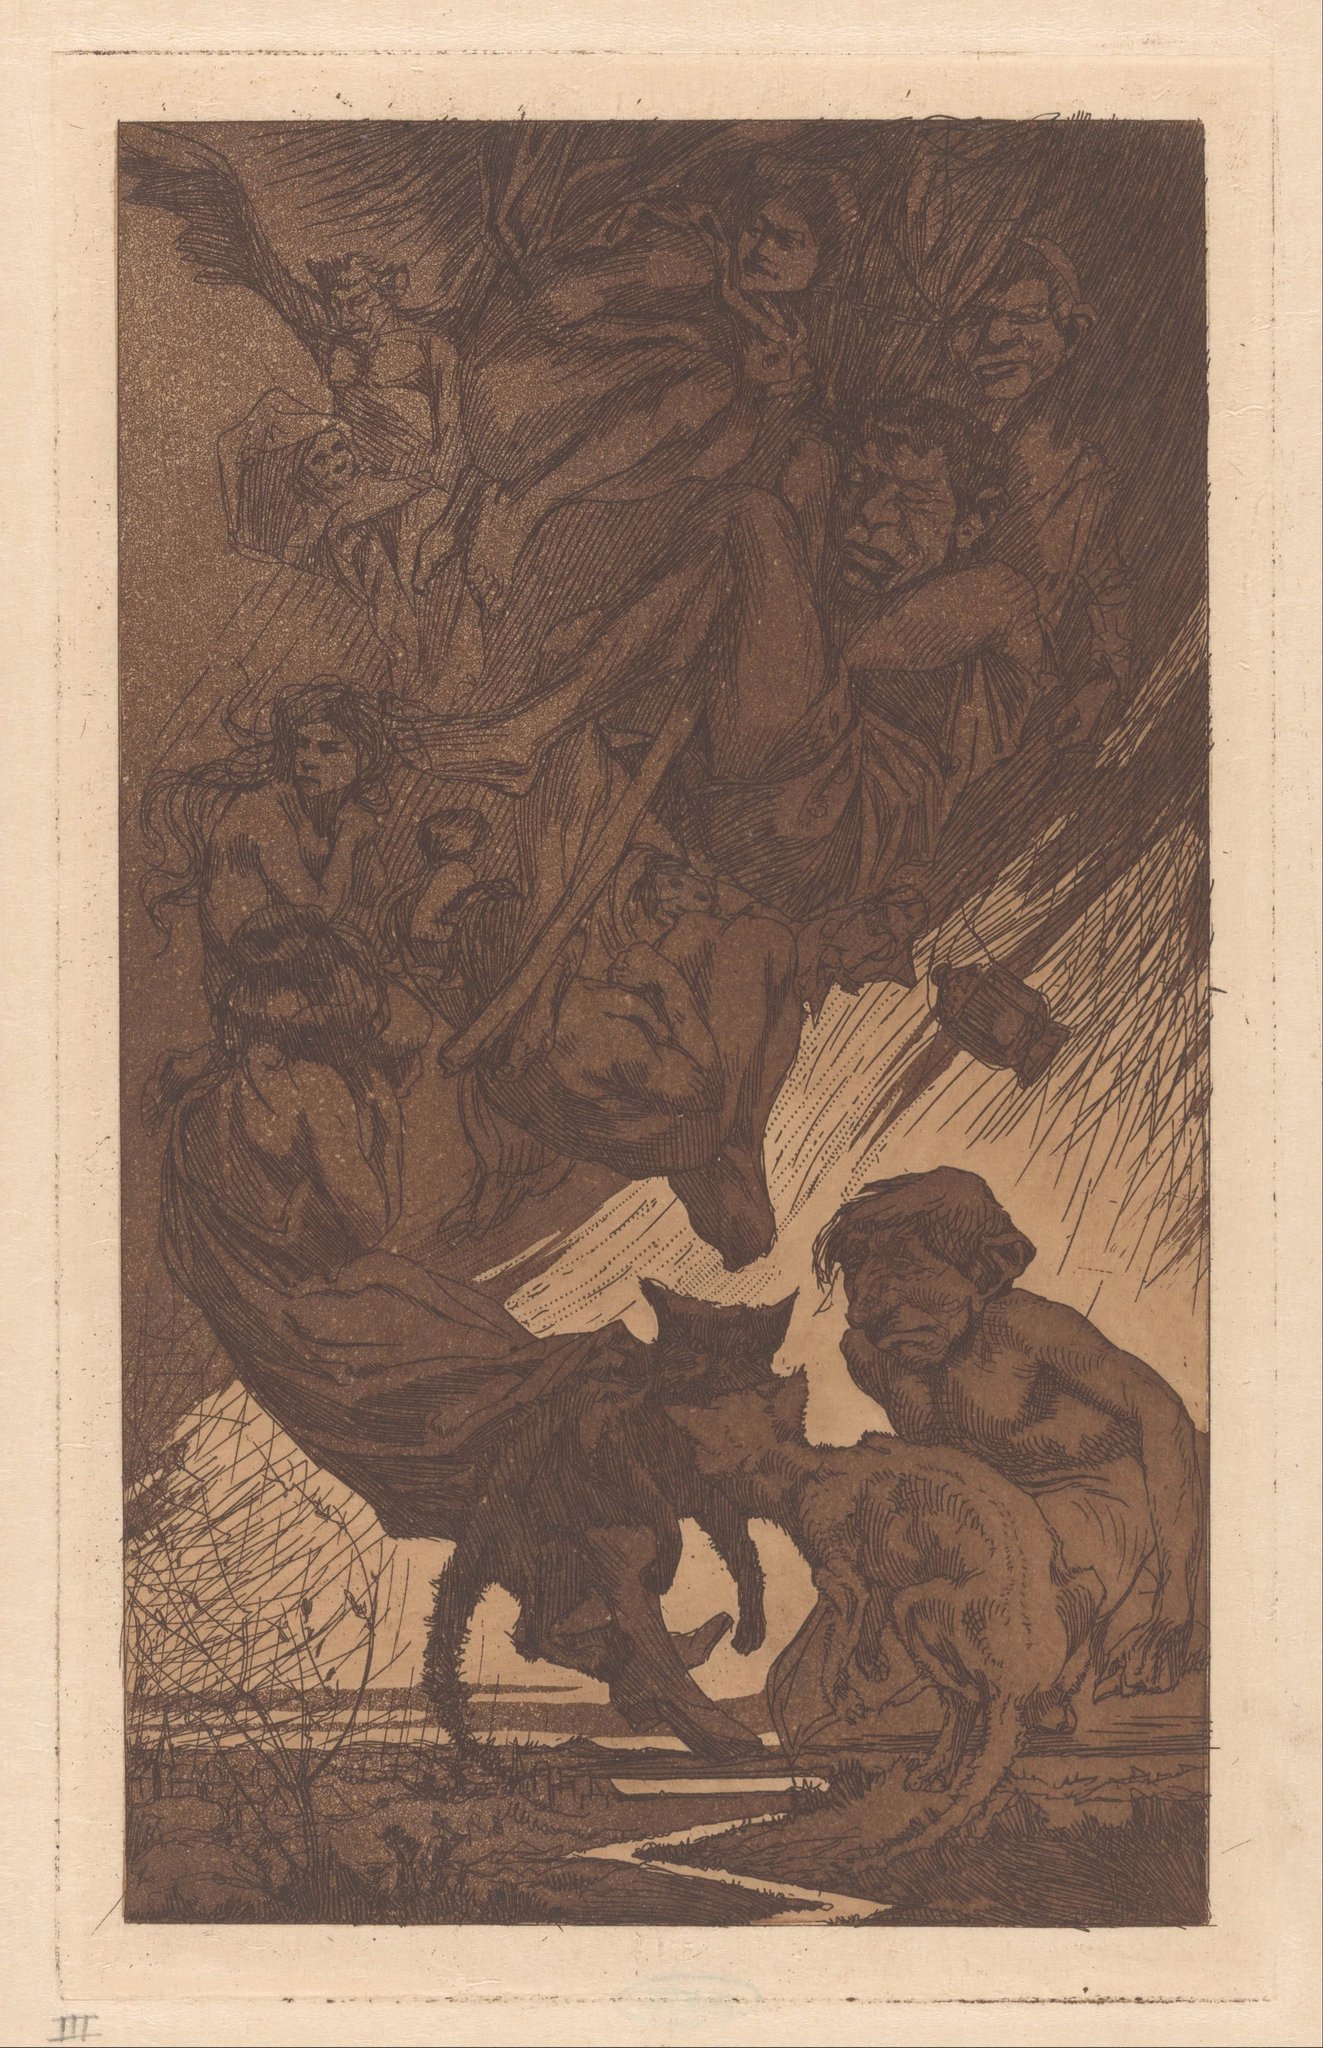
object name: print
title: Zwevende mensen, fantasiewezens en katten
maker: johannes josephus aarts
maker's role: draughtsman, print maker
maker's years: 1871-1934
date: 1881-1934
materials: paper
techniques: aquatint, etching, roulette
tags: movement in the air, cat, surrealia, surrealistic representations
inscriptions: collector's mark: Lugt 2166, collector's mark: Lugt 2228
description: Onder hen een vlak landschap met links bebouwing en in het midden een rivier.